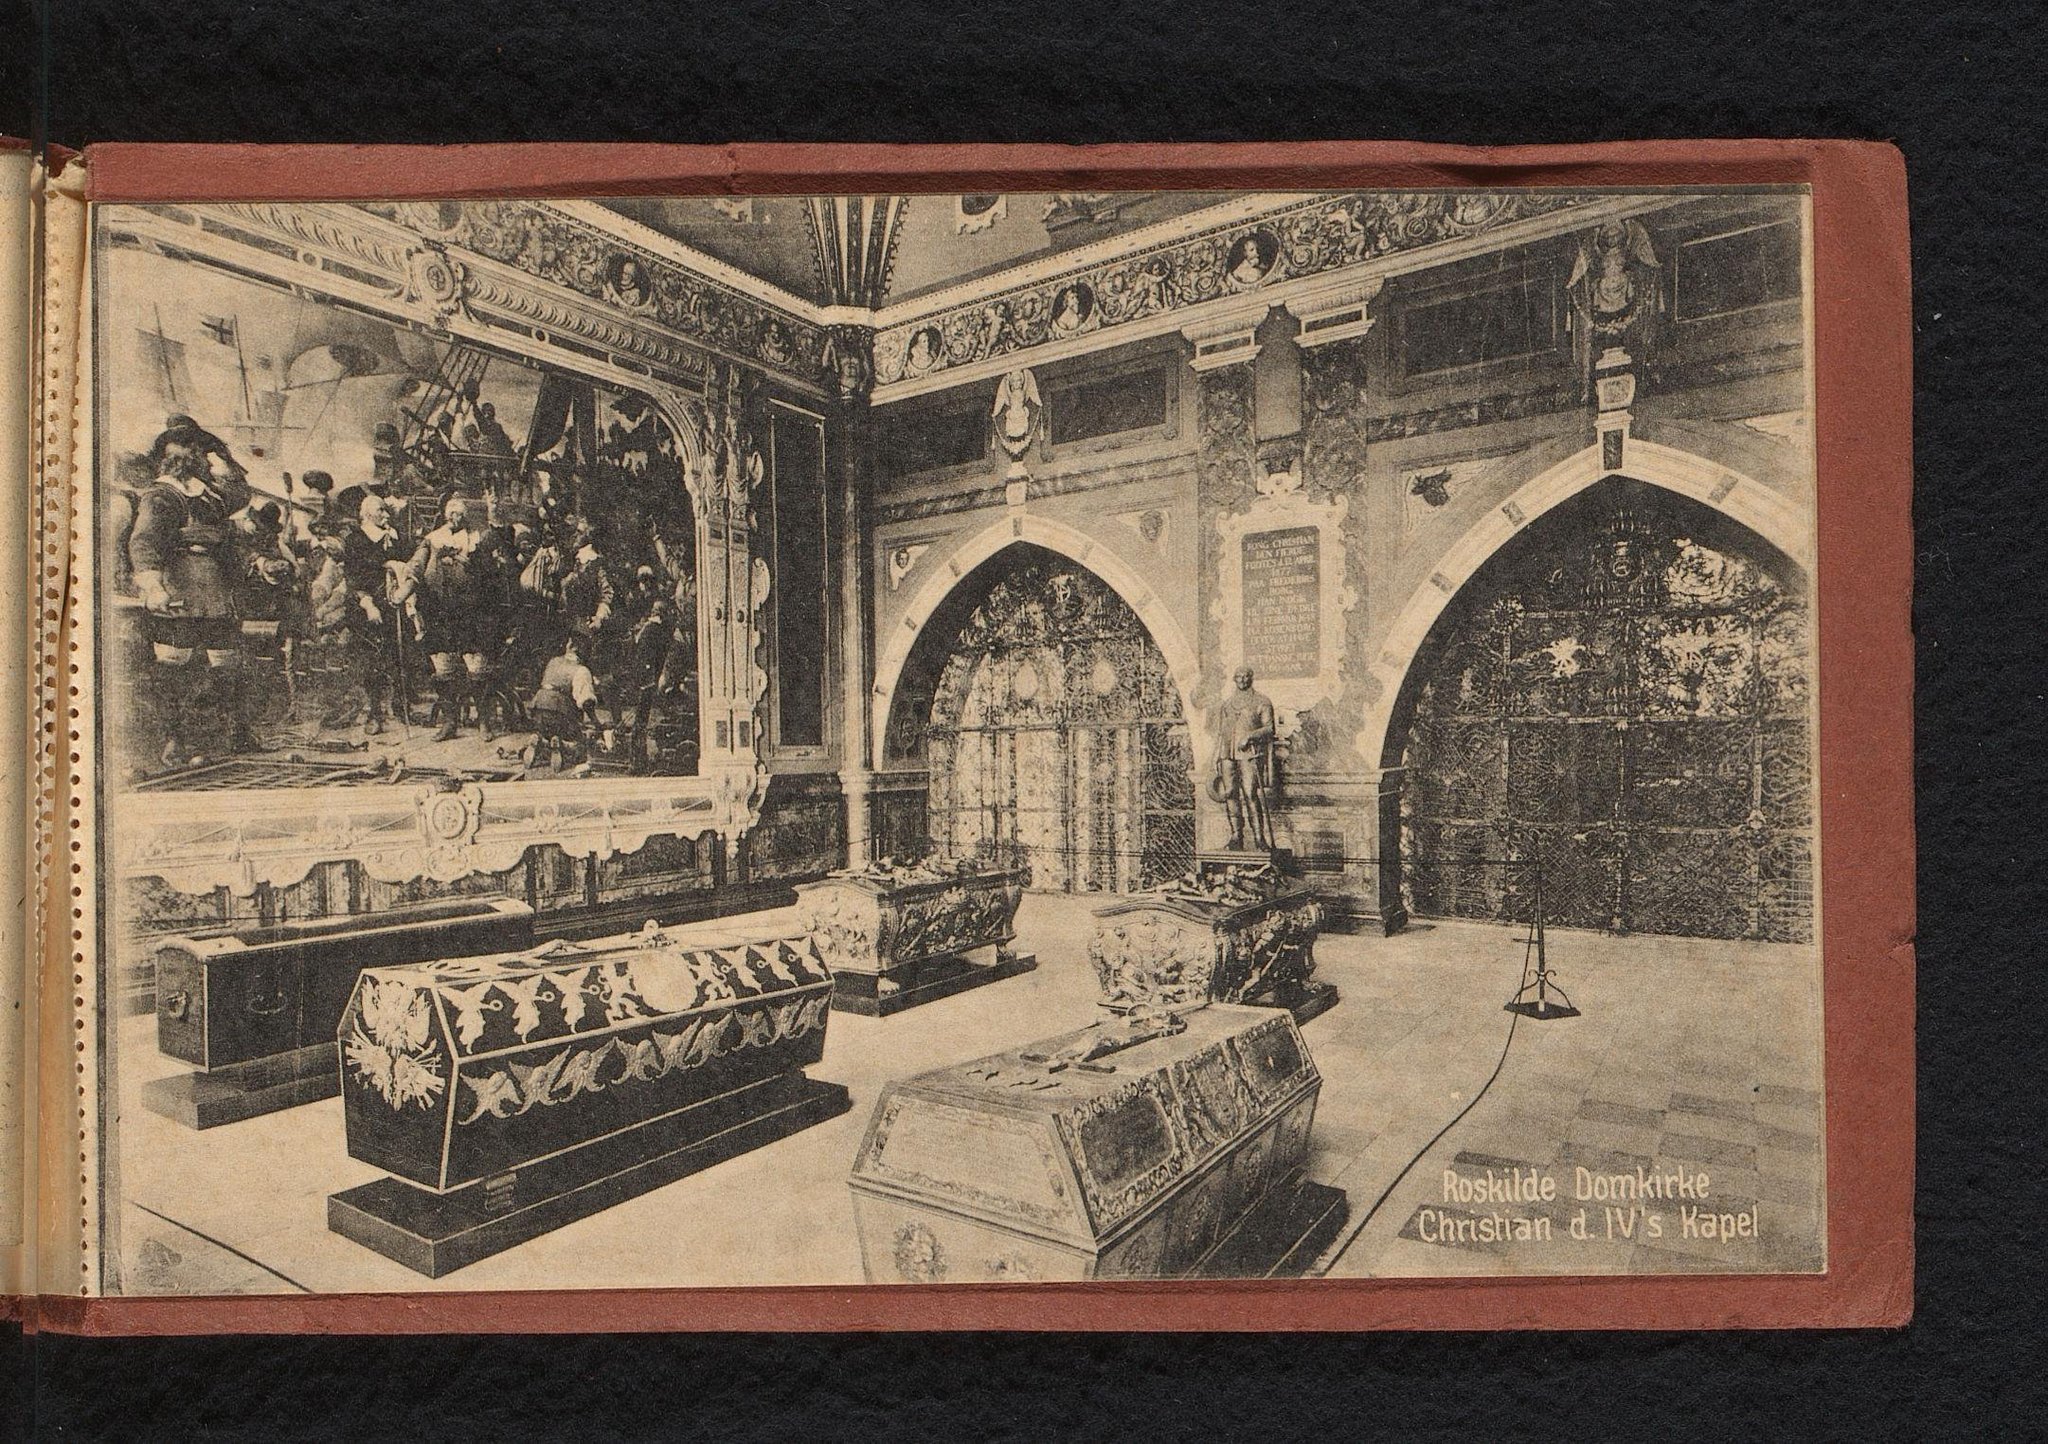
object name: photomechanical print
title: Roskilde Domkirke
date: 1906-1920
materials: cardboard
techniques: photograph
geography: roskilde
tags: grave, tomb, interior of church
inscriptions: mark: ‘CS’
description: Prentbriefkaart maakt deel uit van een album.